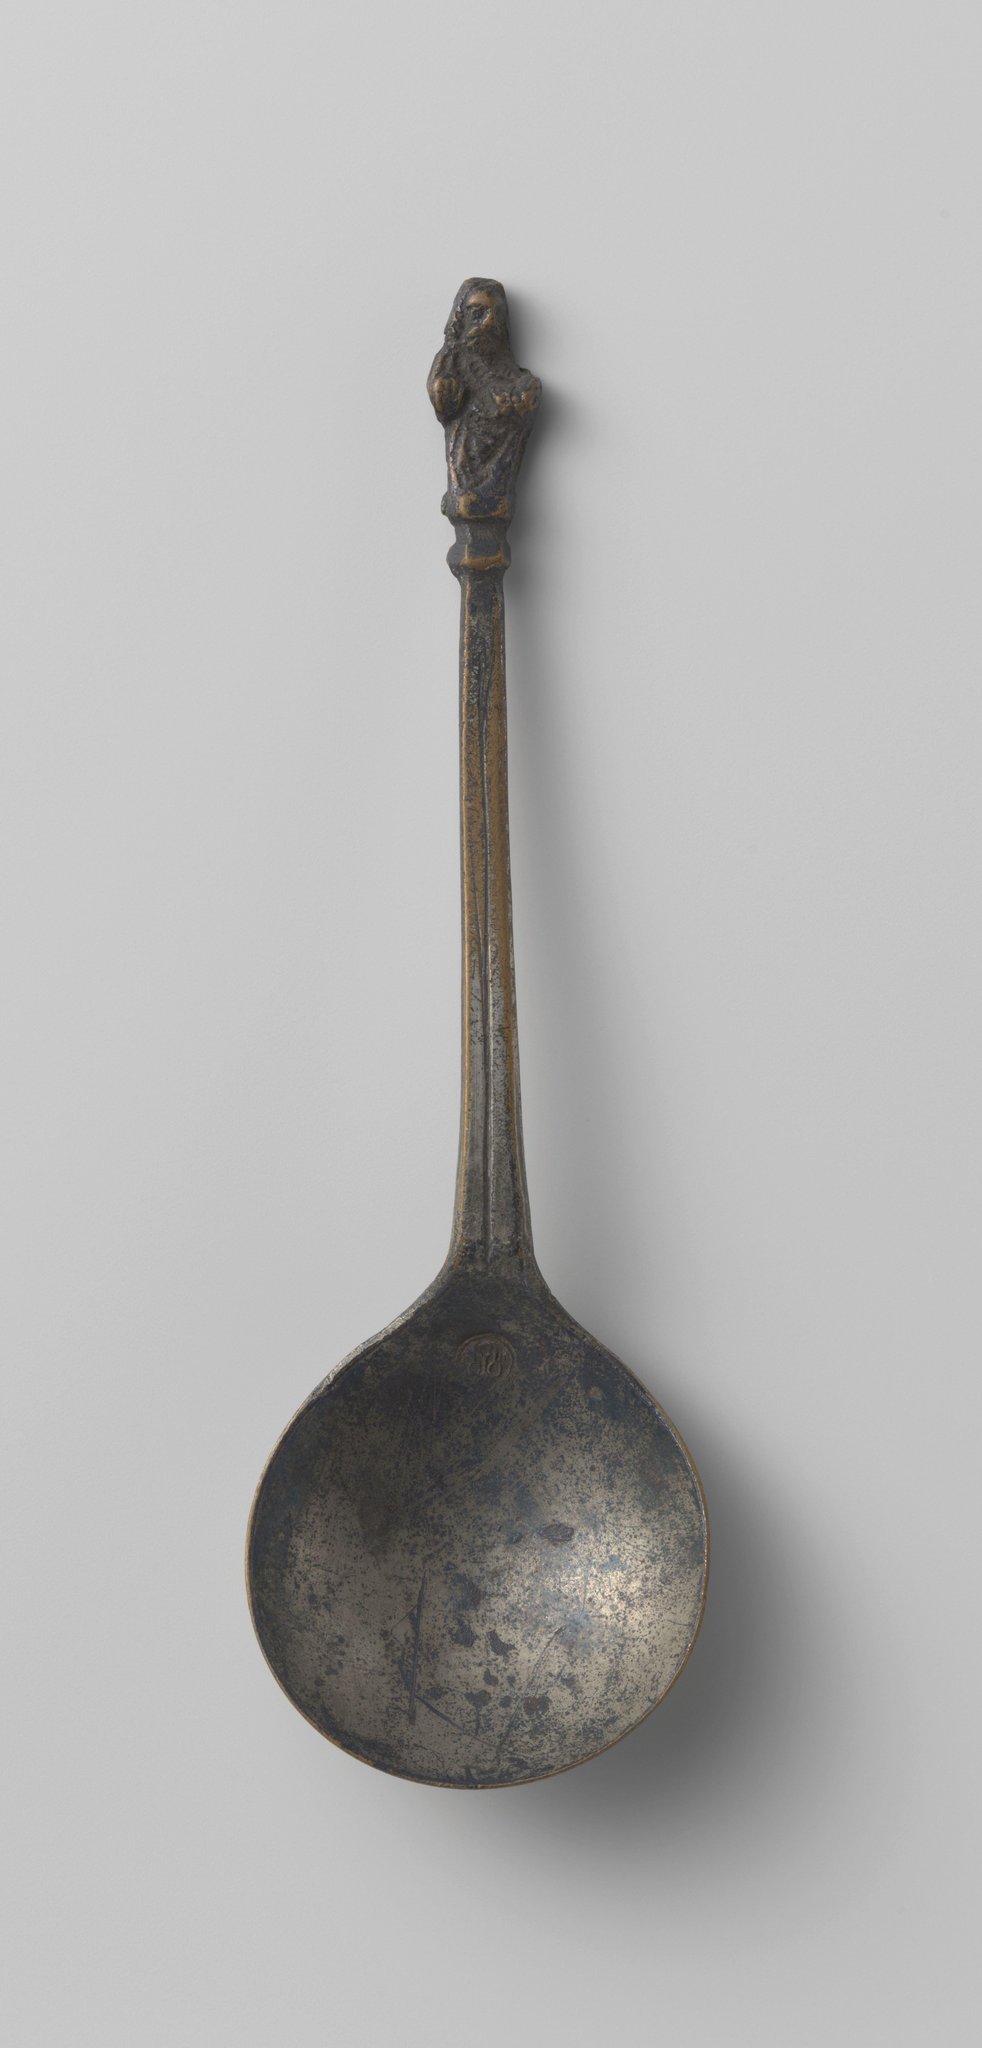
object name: spoon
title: Apostellepel met ronde bak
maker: Anonymous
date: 1650-1675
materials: brass, tin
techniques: casting, tinning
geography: england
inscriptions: quality mark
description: De gegoten lepel heeft een ronde bak, die overgaat in een overlangs gegroefde steel, waarop een apostel.